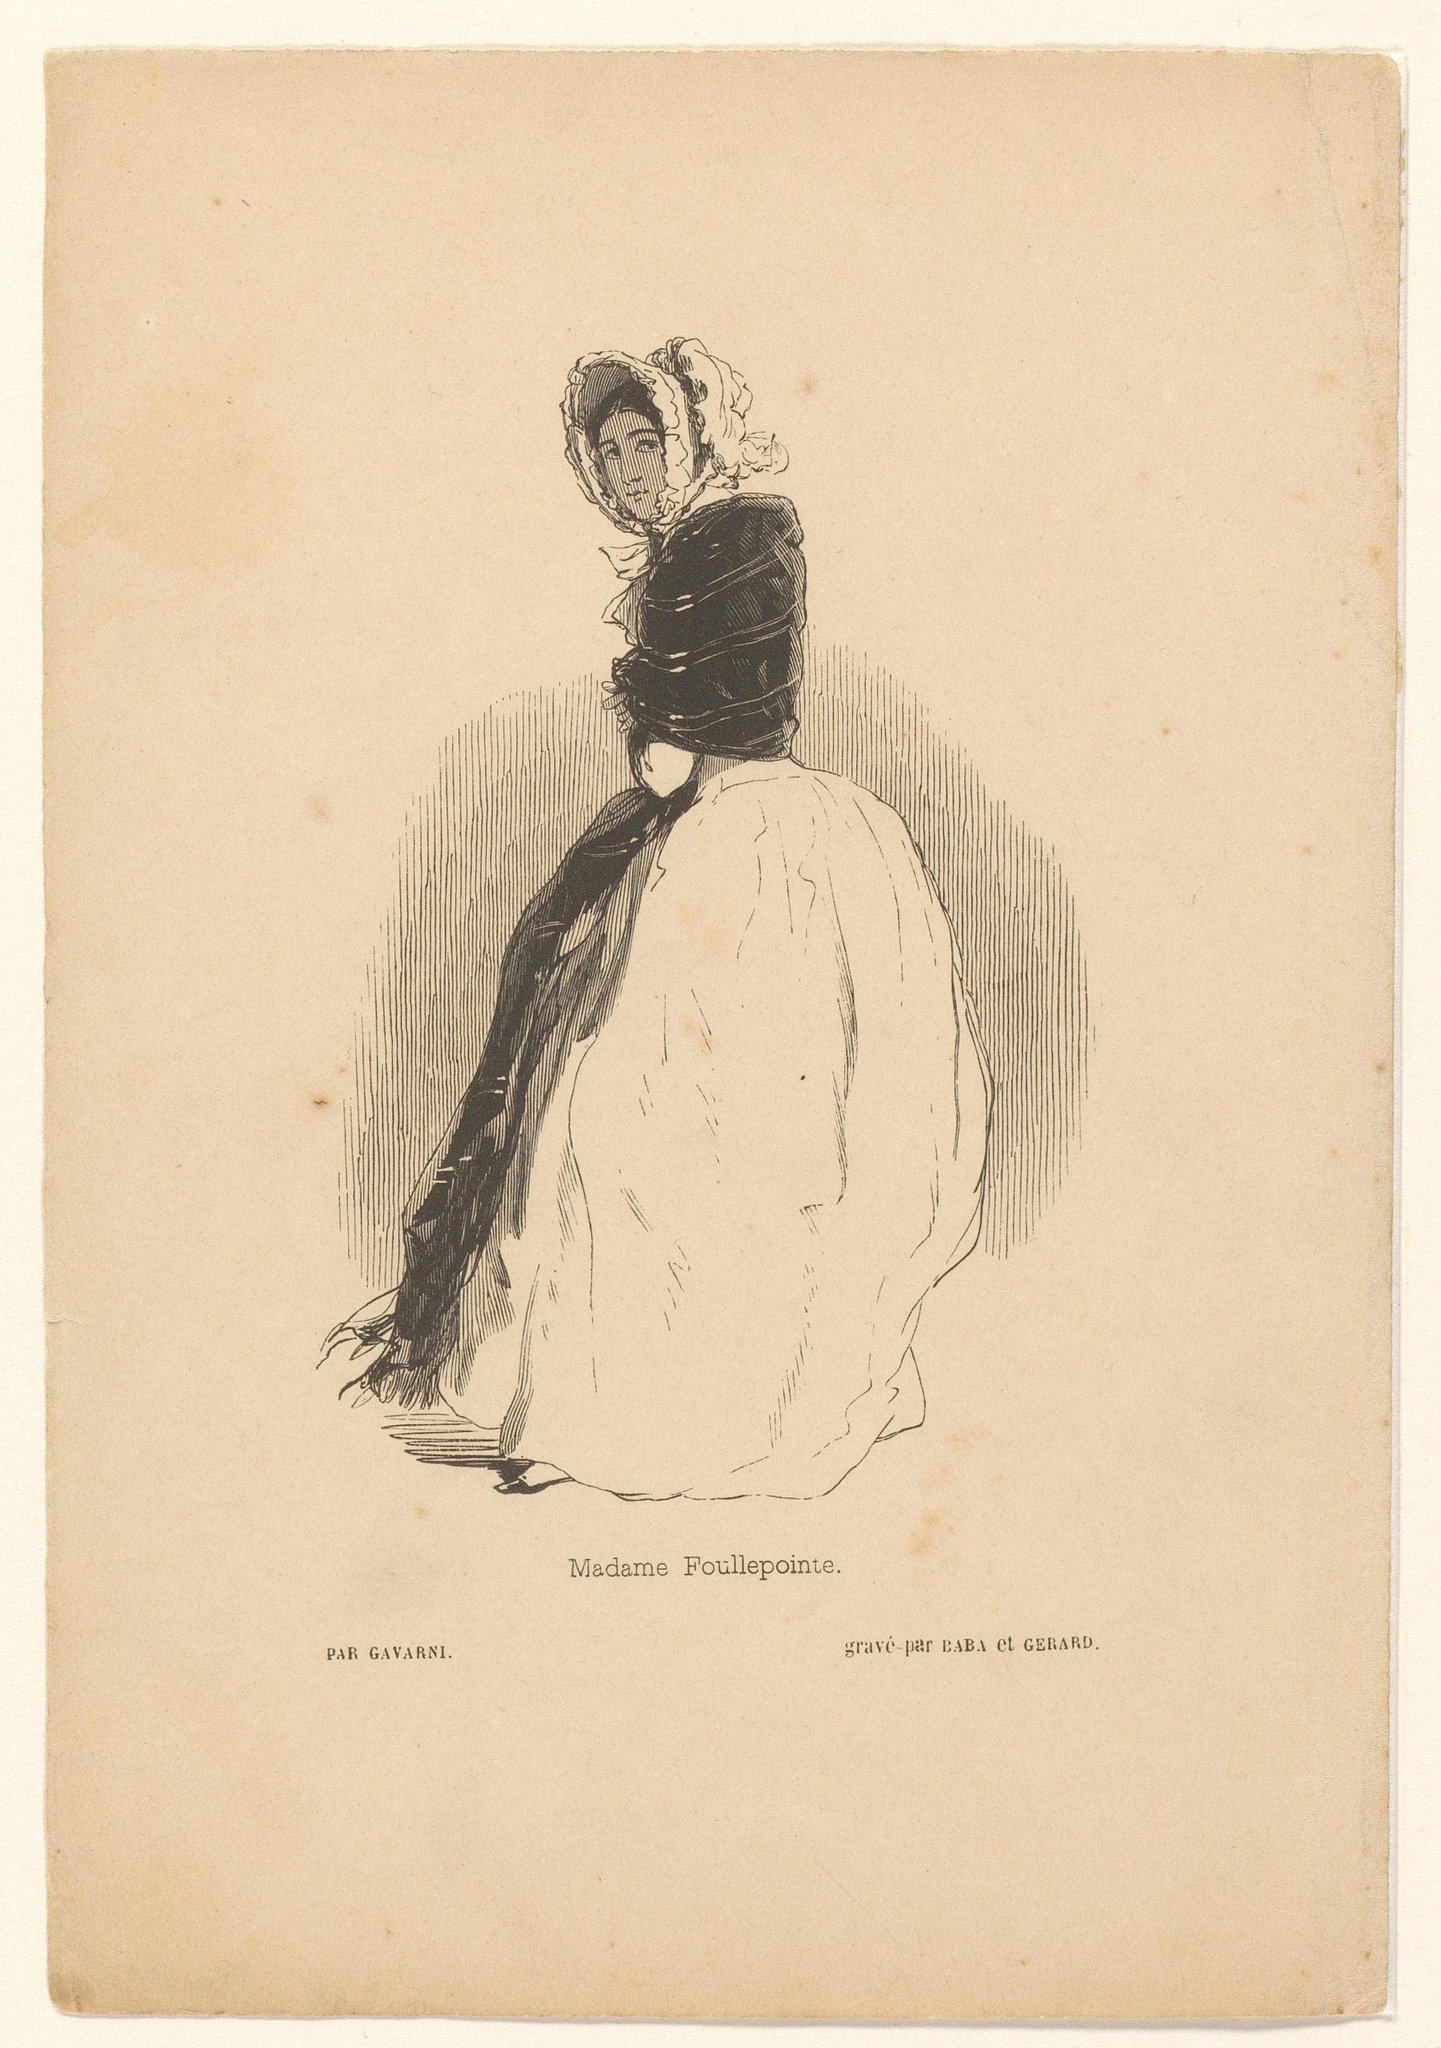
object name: print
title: Mevrouw Foullepointe uit Petites Misères de la Vie Conjugale van Honoré de Balzac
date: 1830-1862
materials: paper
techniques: engraving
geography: france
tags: paris, honoré de balzac, female literary characters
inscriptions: signature: ‘gravé par Bara et Gerard’